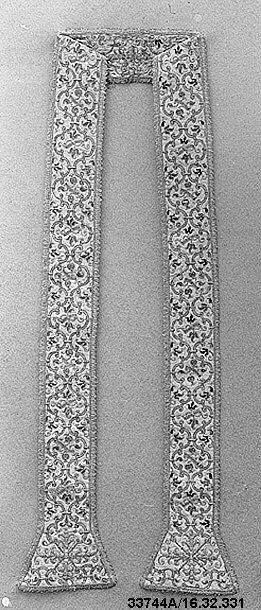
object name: stole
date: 1501-1600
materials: metal thread, silk